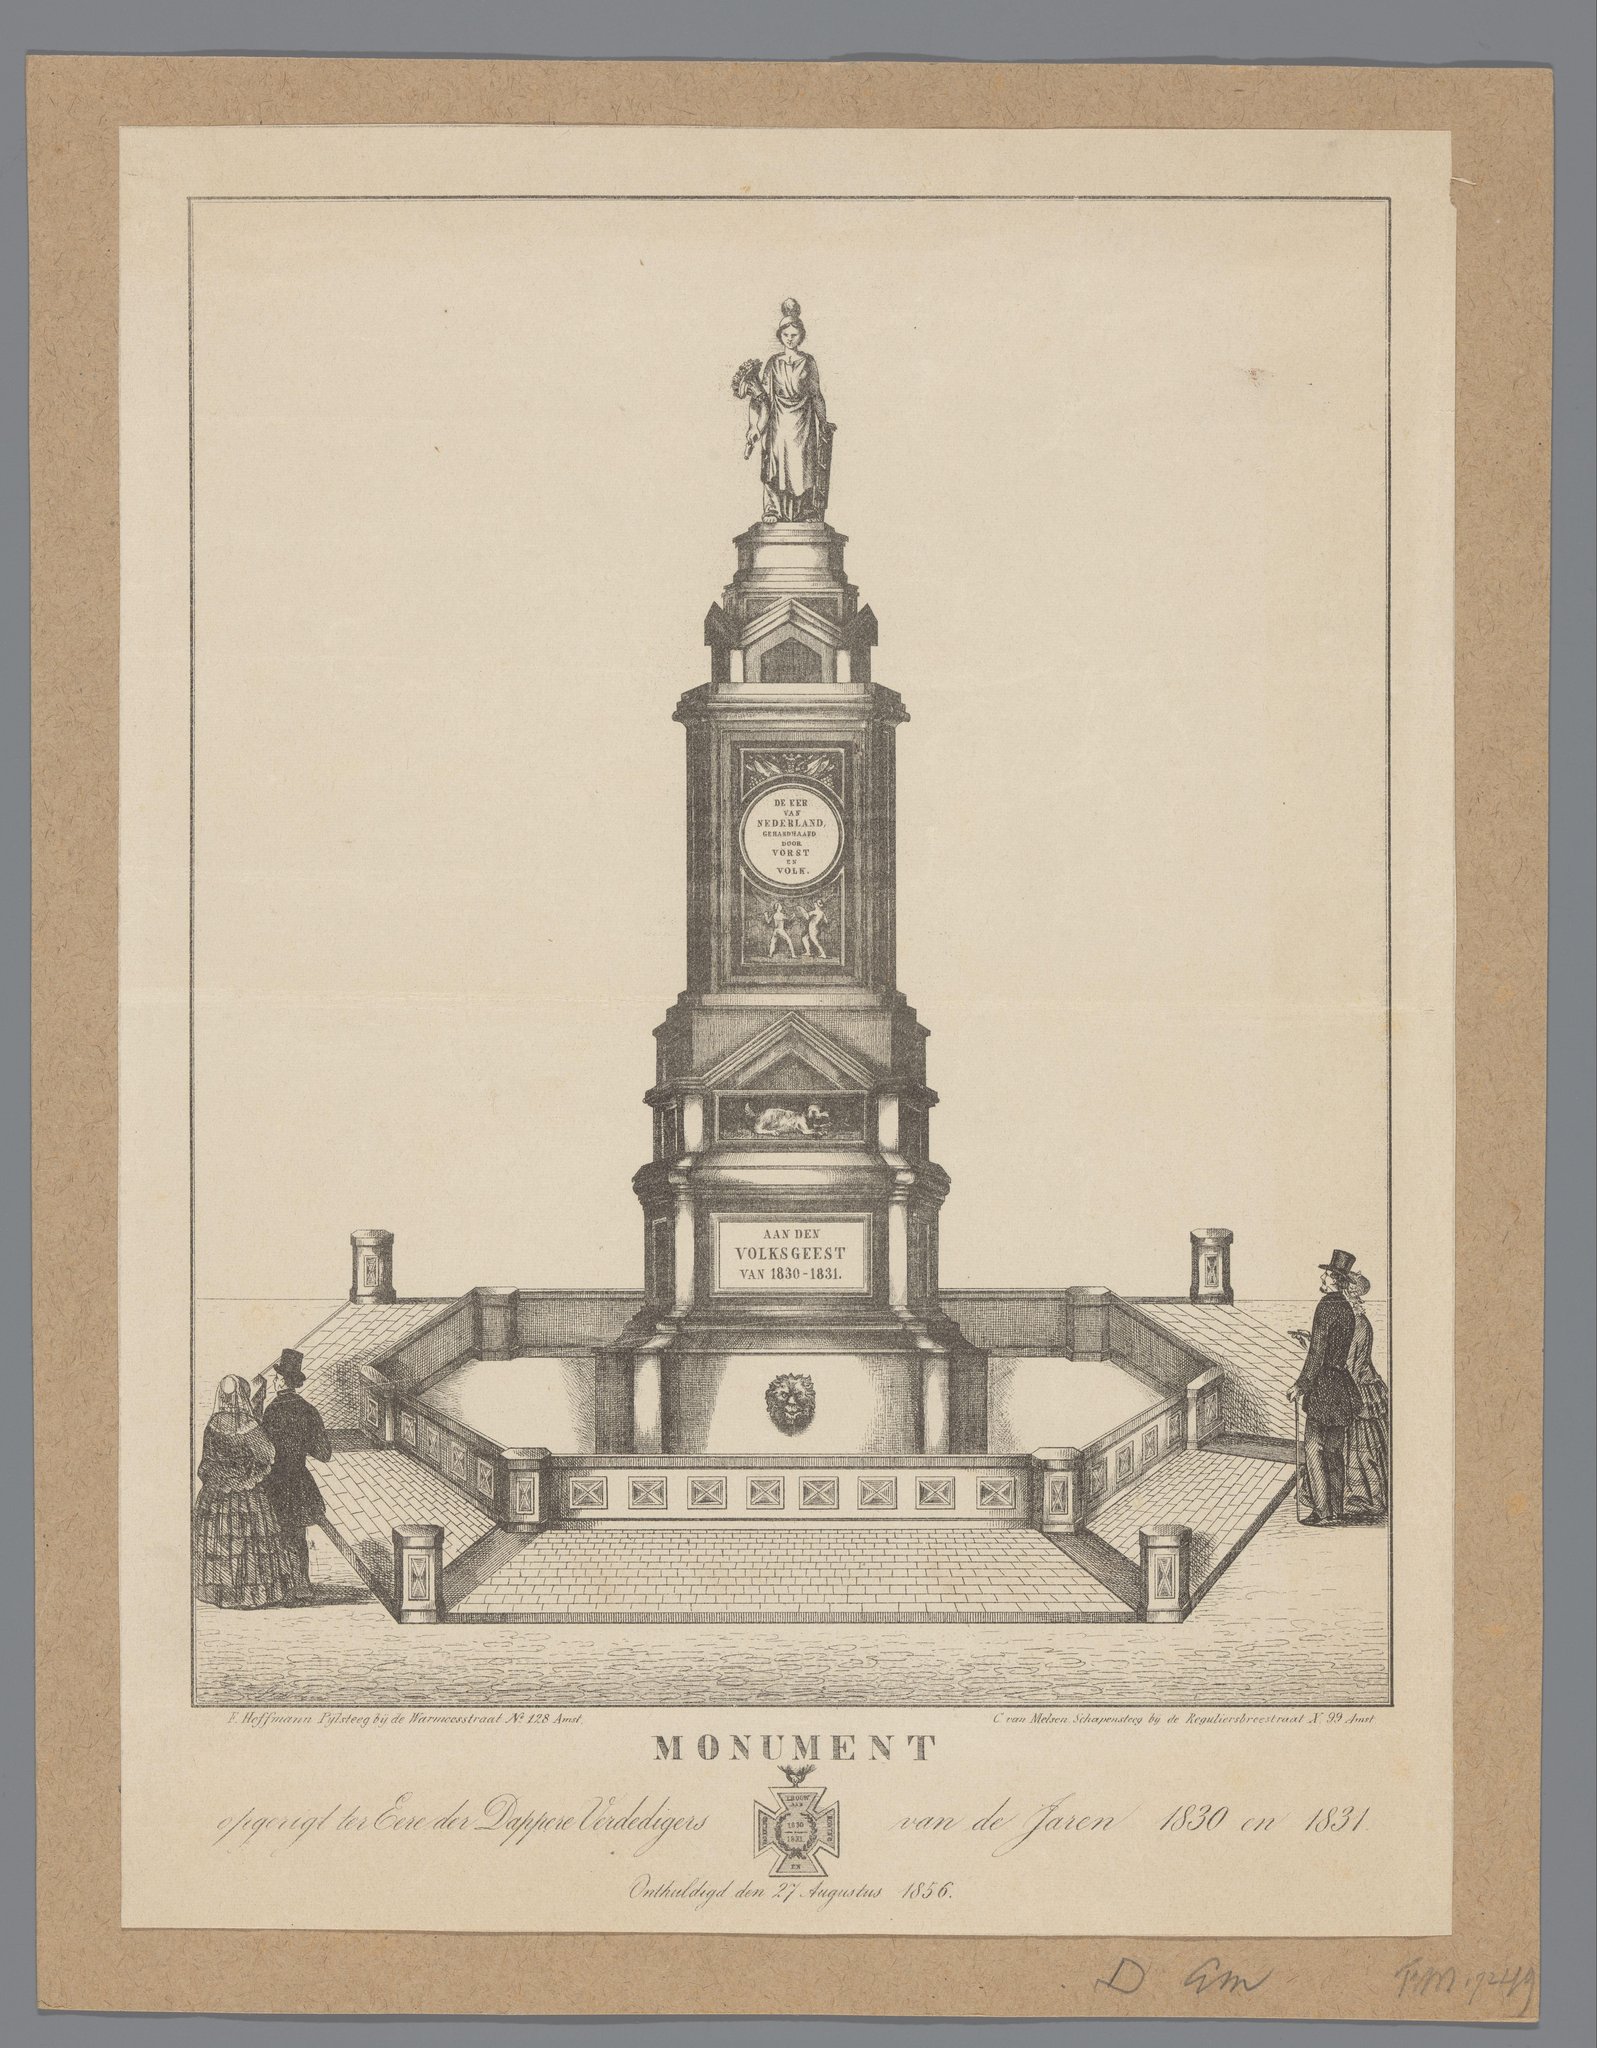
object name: print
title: Monument De Eendracht op de Dam te Amsterdam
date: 1856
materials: paper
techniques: lithograph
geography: amsterdam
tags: monument, statue, medals and other marks of military honour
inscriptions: annotation: ‘Den Heer van Erkelens’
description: Het monument Gedenkteken aan de Volksgeest van 1830 en 1831, bekend als Naatje op de Dam, onthuld te Amsterdam op 27 augustus 1856. Links en rechts van het monument enkele bezoekers. Onderaan in de titel het Metalen Kruis.